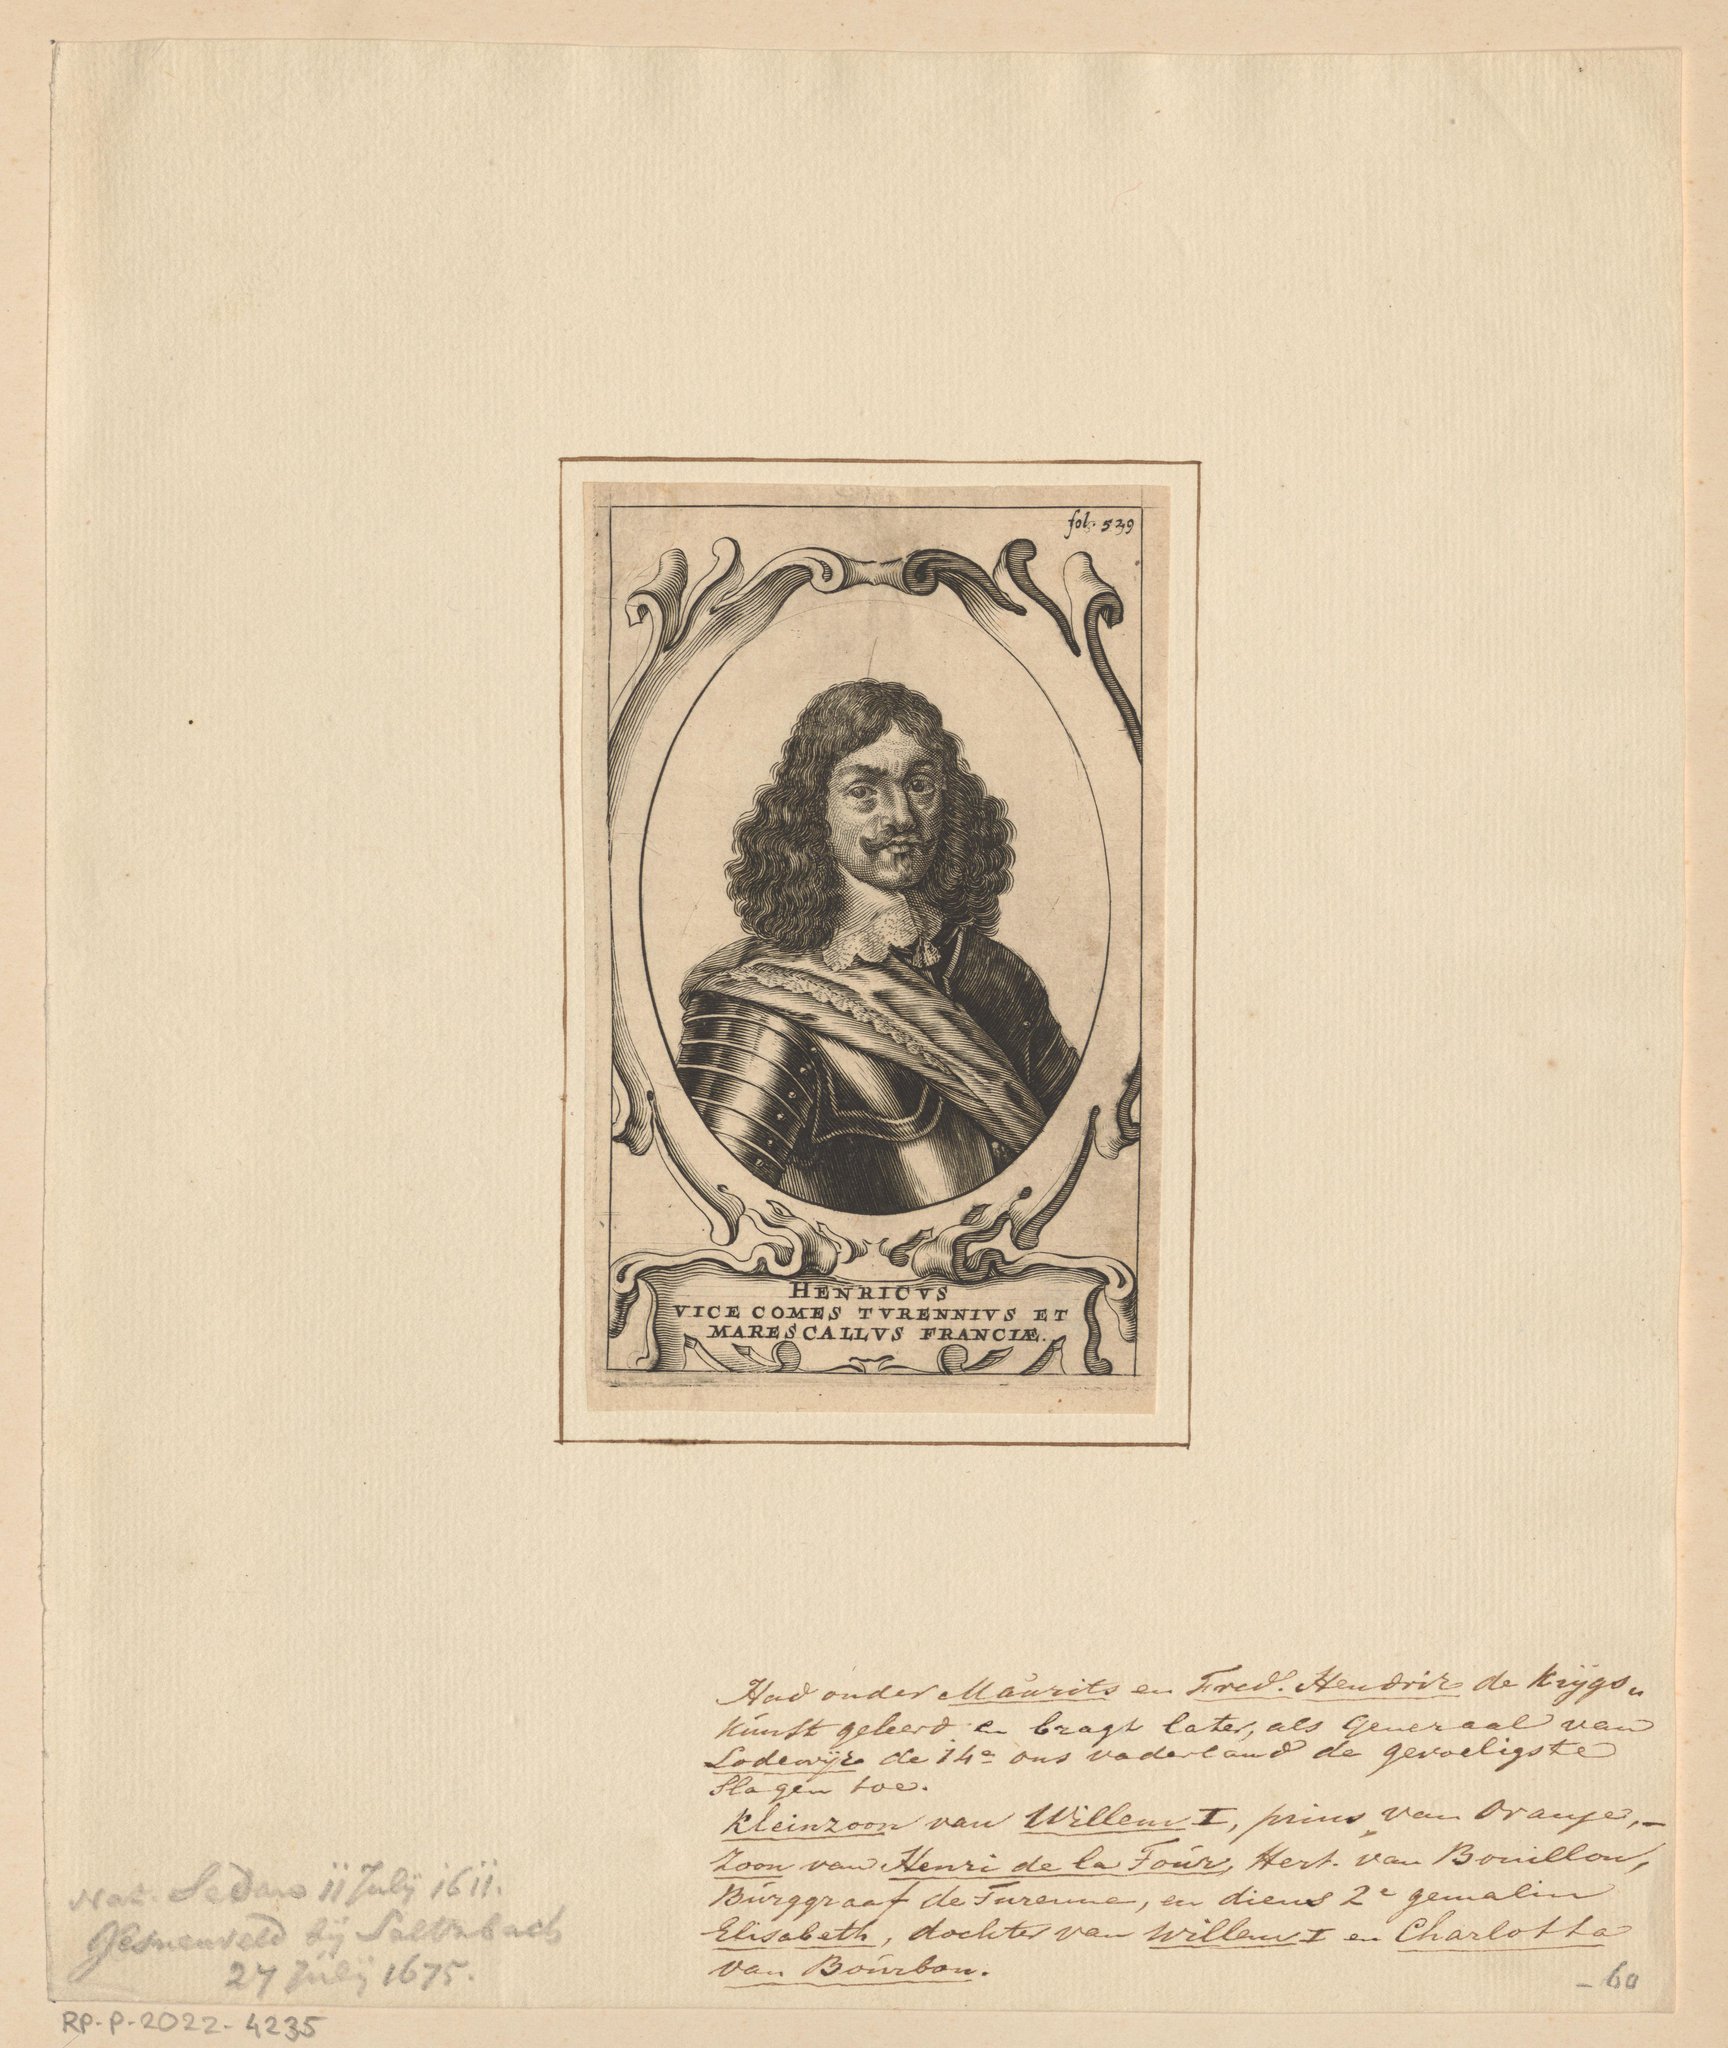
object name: book illustration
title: Portret van Henri de La Tour d'Auvergne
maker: Anonymous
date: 1656-1666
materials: paper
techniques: engraving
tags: commander-in-chief, general, marshal, armour, historical persons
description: Prent waarschijnlijk uit: Brachelius, Johannes Adolphus. Historia nostri temporis, dat is geschiedenis onses tijdts (…). Rotterdam: Andries van Hoogenhuysen, 1656. Prent ook gebruikt in de 1659- en 1666-editie